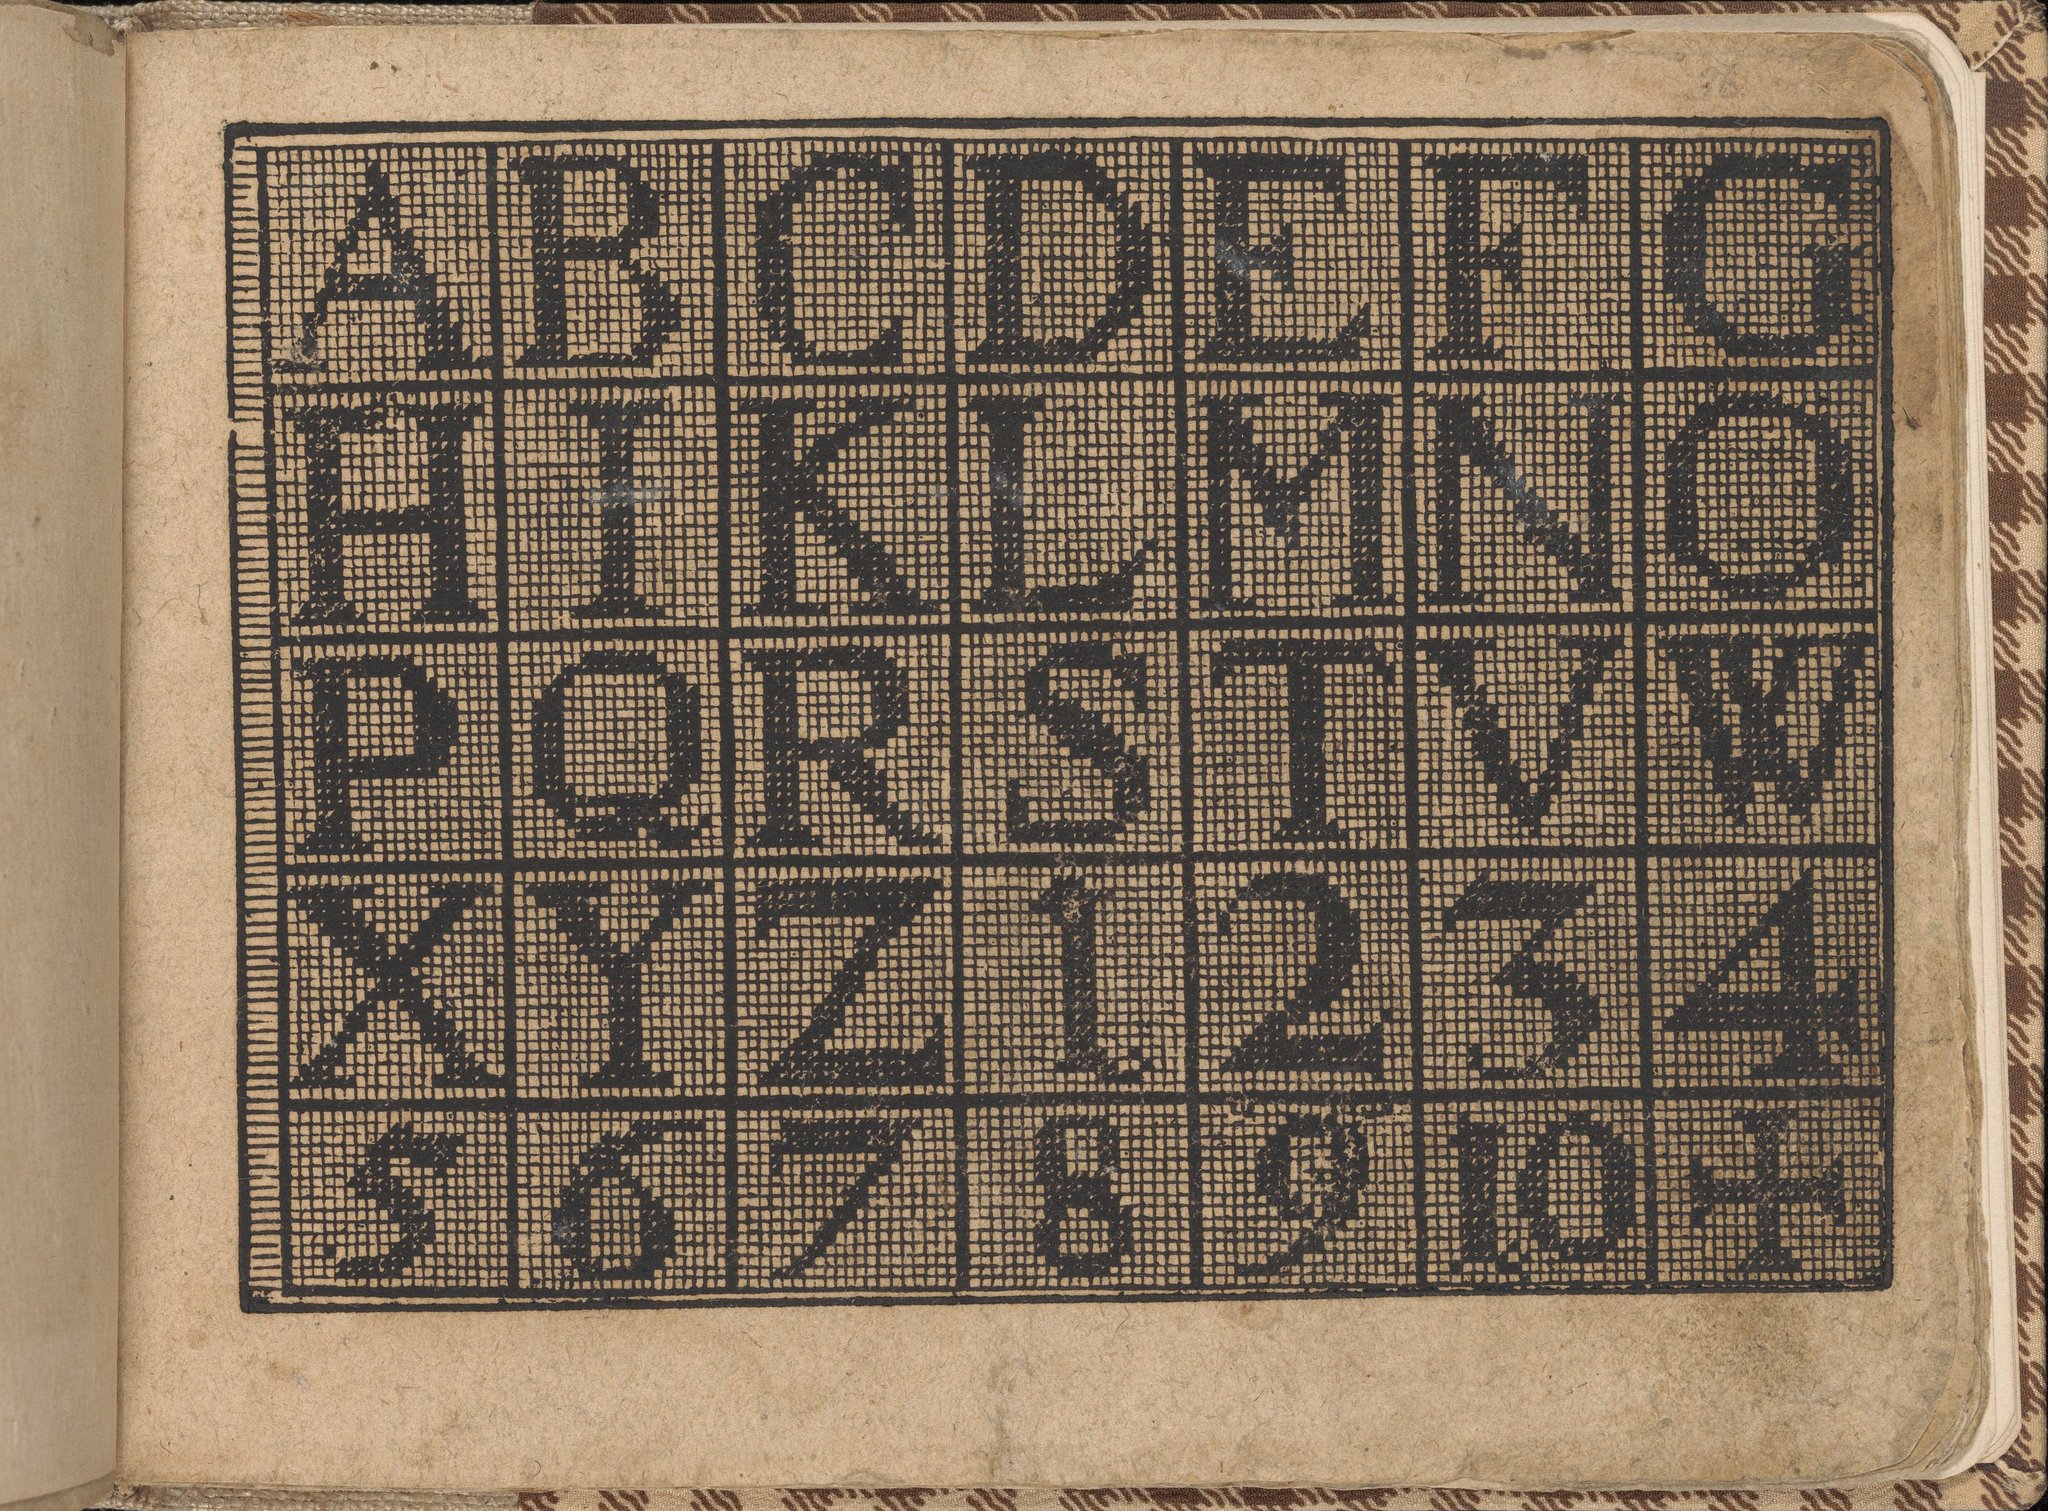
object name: book print ornament architecture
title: New Künstlichs Modelbuch (Page 36 recto)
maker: bernhard jobin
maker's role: publisher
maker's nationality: swiss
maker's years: 1535-1597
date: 1600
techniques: woodcut